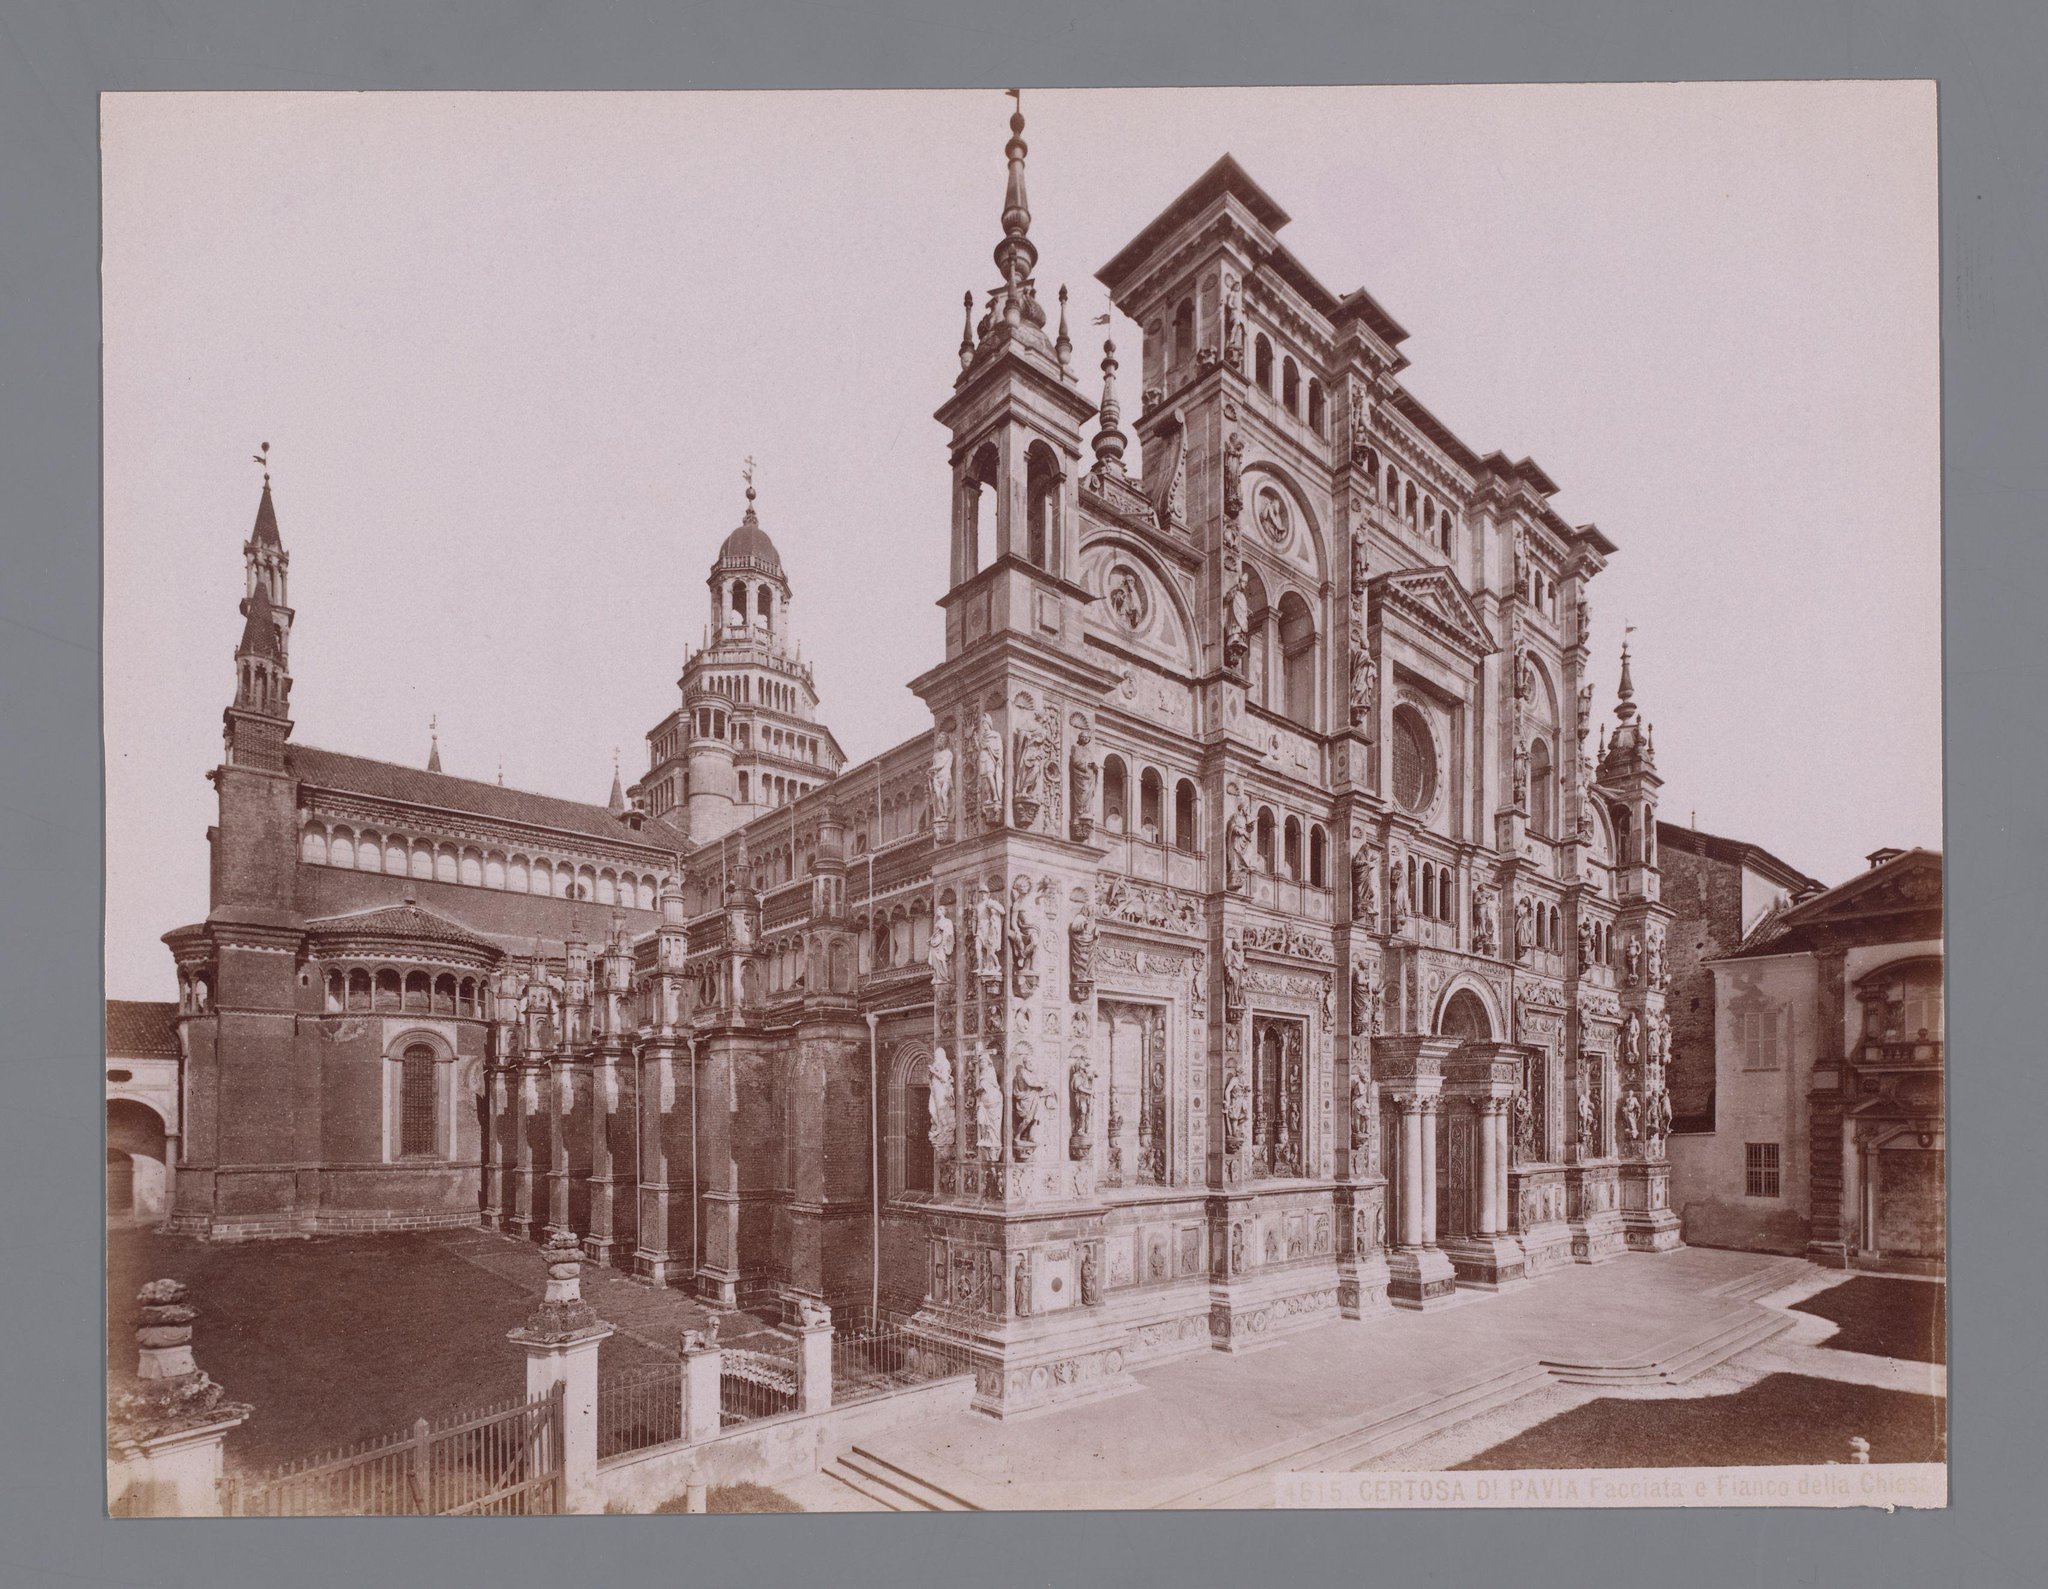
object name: photograph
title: Facciata e Fianco della Chiesa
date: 1856-1881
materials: cardboard, paper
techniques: albumen print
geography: pavia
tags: church (exterior)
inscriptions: inscription: ‘Brogi (+)’, number: ‘4615.’, number: ‘13’